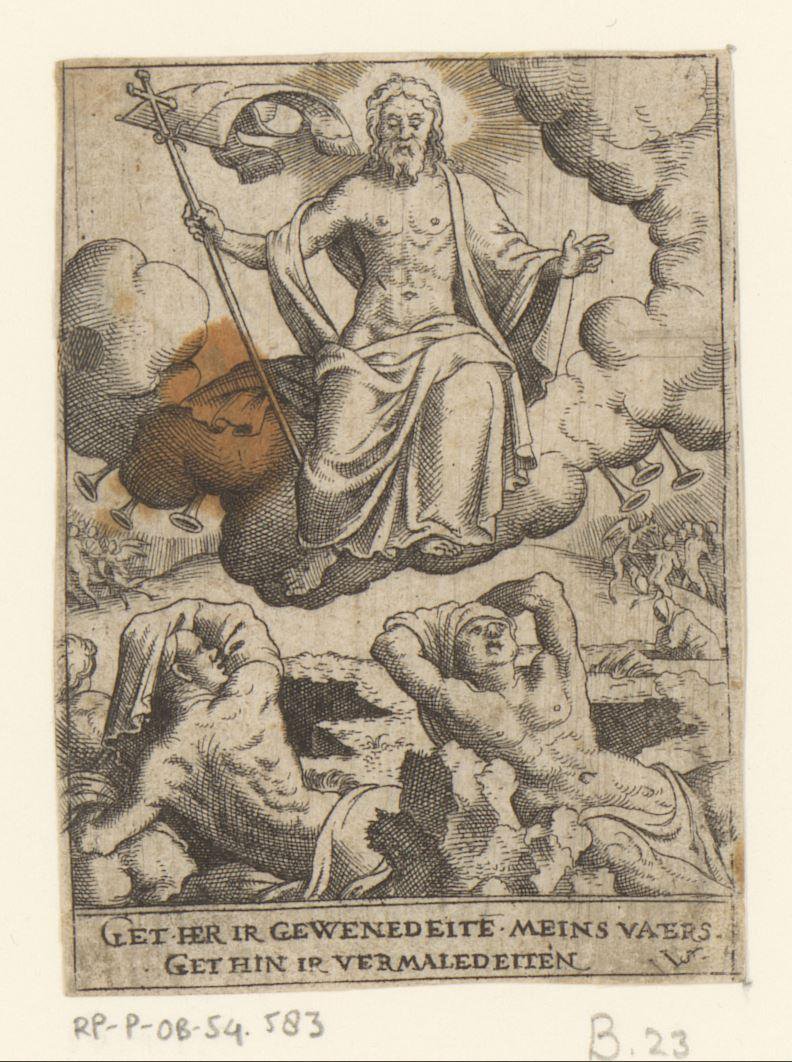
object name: print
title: Laatste Oordeel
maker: virgilius solis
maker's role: draughtsman, print maker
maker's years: 1514-1562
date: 1524-1562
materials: paper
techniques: engraving, etching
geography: nuremberg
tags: last judgement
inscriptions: collector's mark: Lugt 2228, number: ‘76’